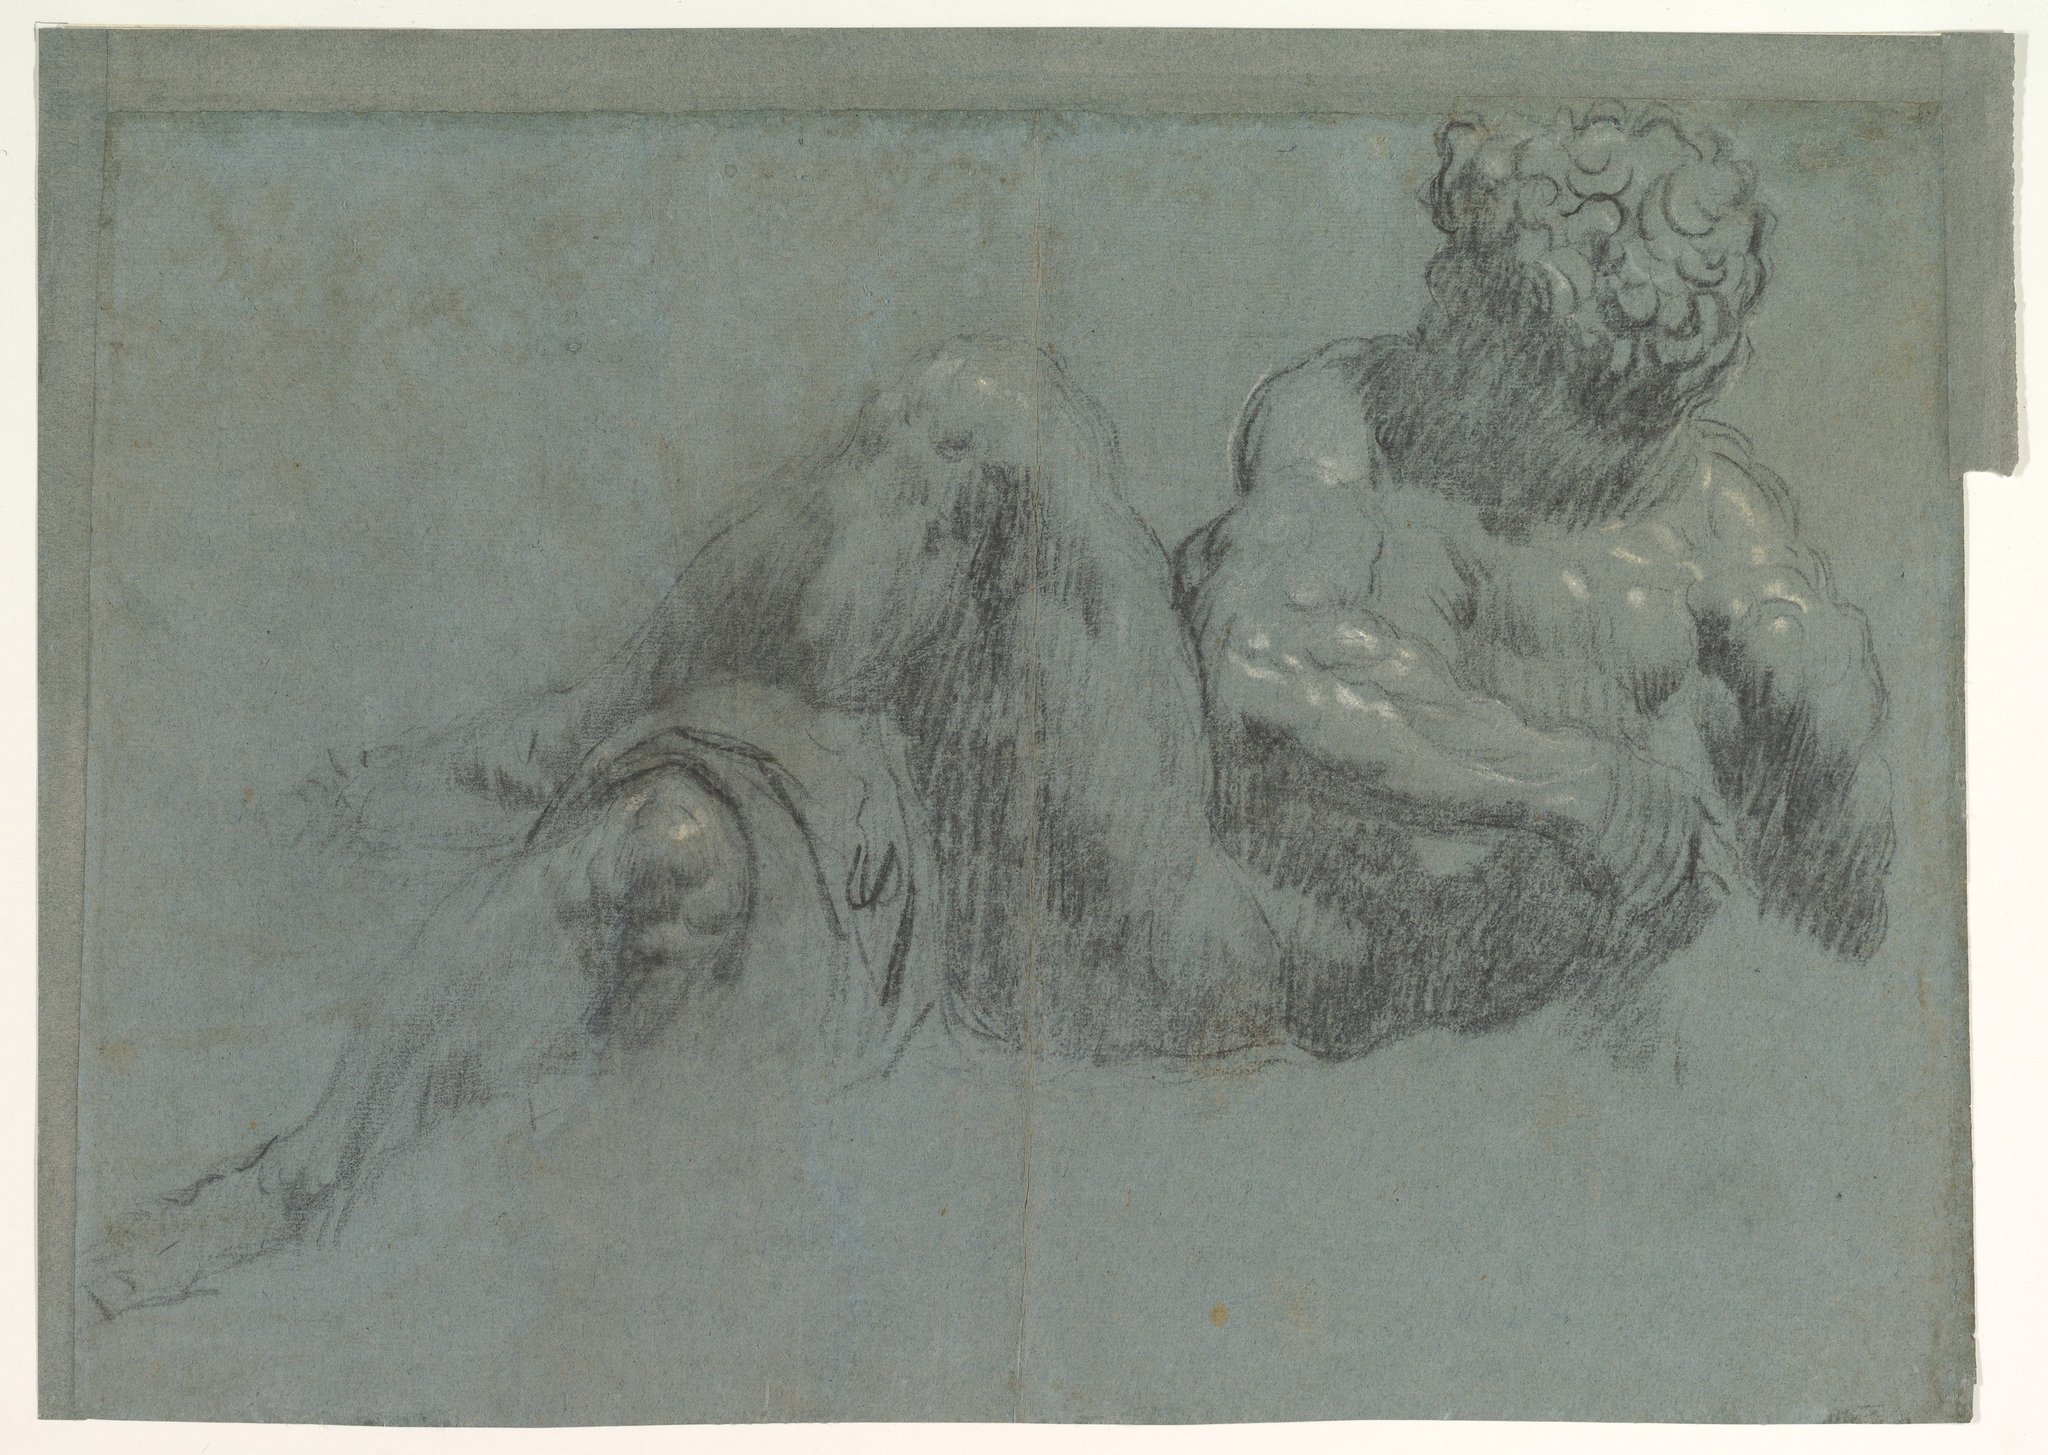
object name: drawing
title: Study after Michelangelo's Giorno (recto and verso)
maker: jacopo tintoretto (jacopo robusti)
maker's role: artist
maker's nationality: italian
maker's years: 1518-1594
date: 1550-1555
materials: chalk, paper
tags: men